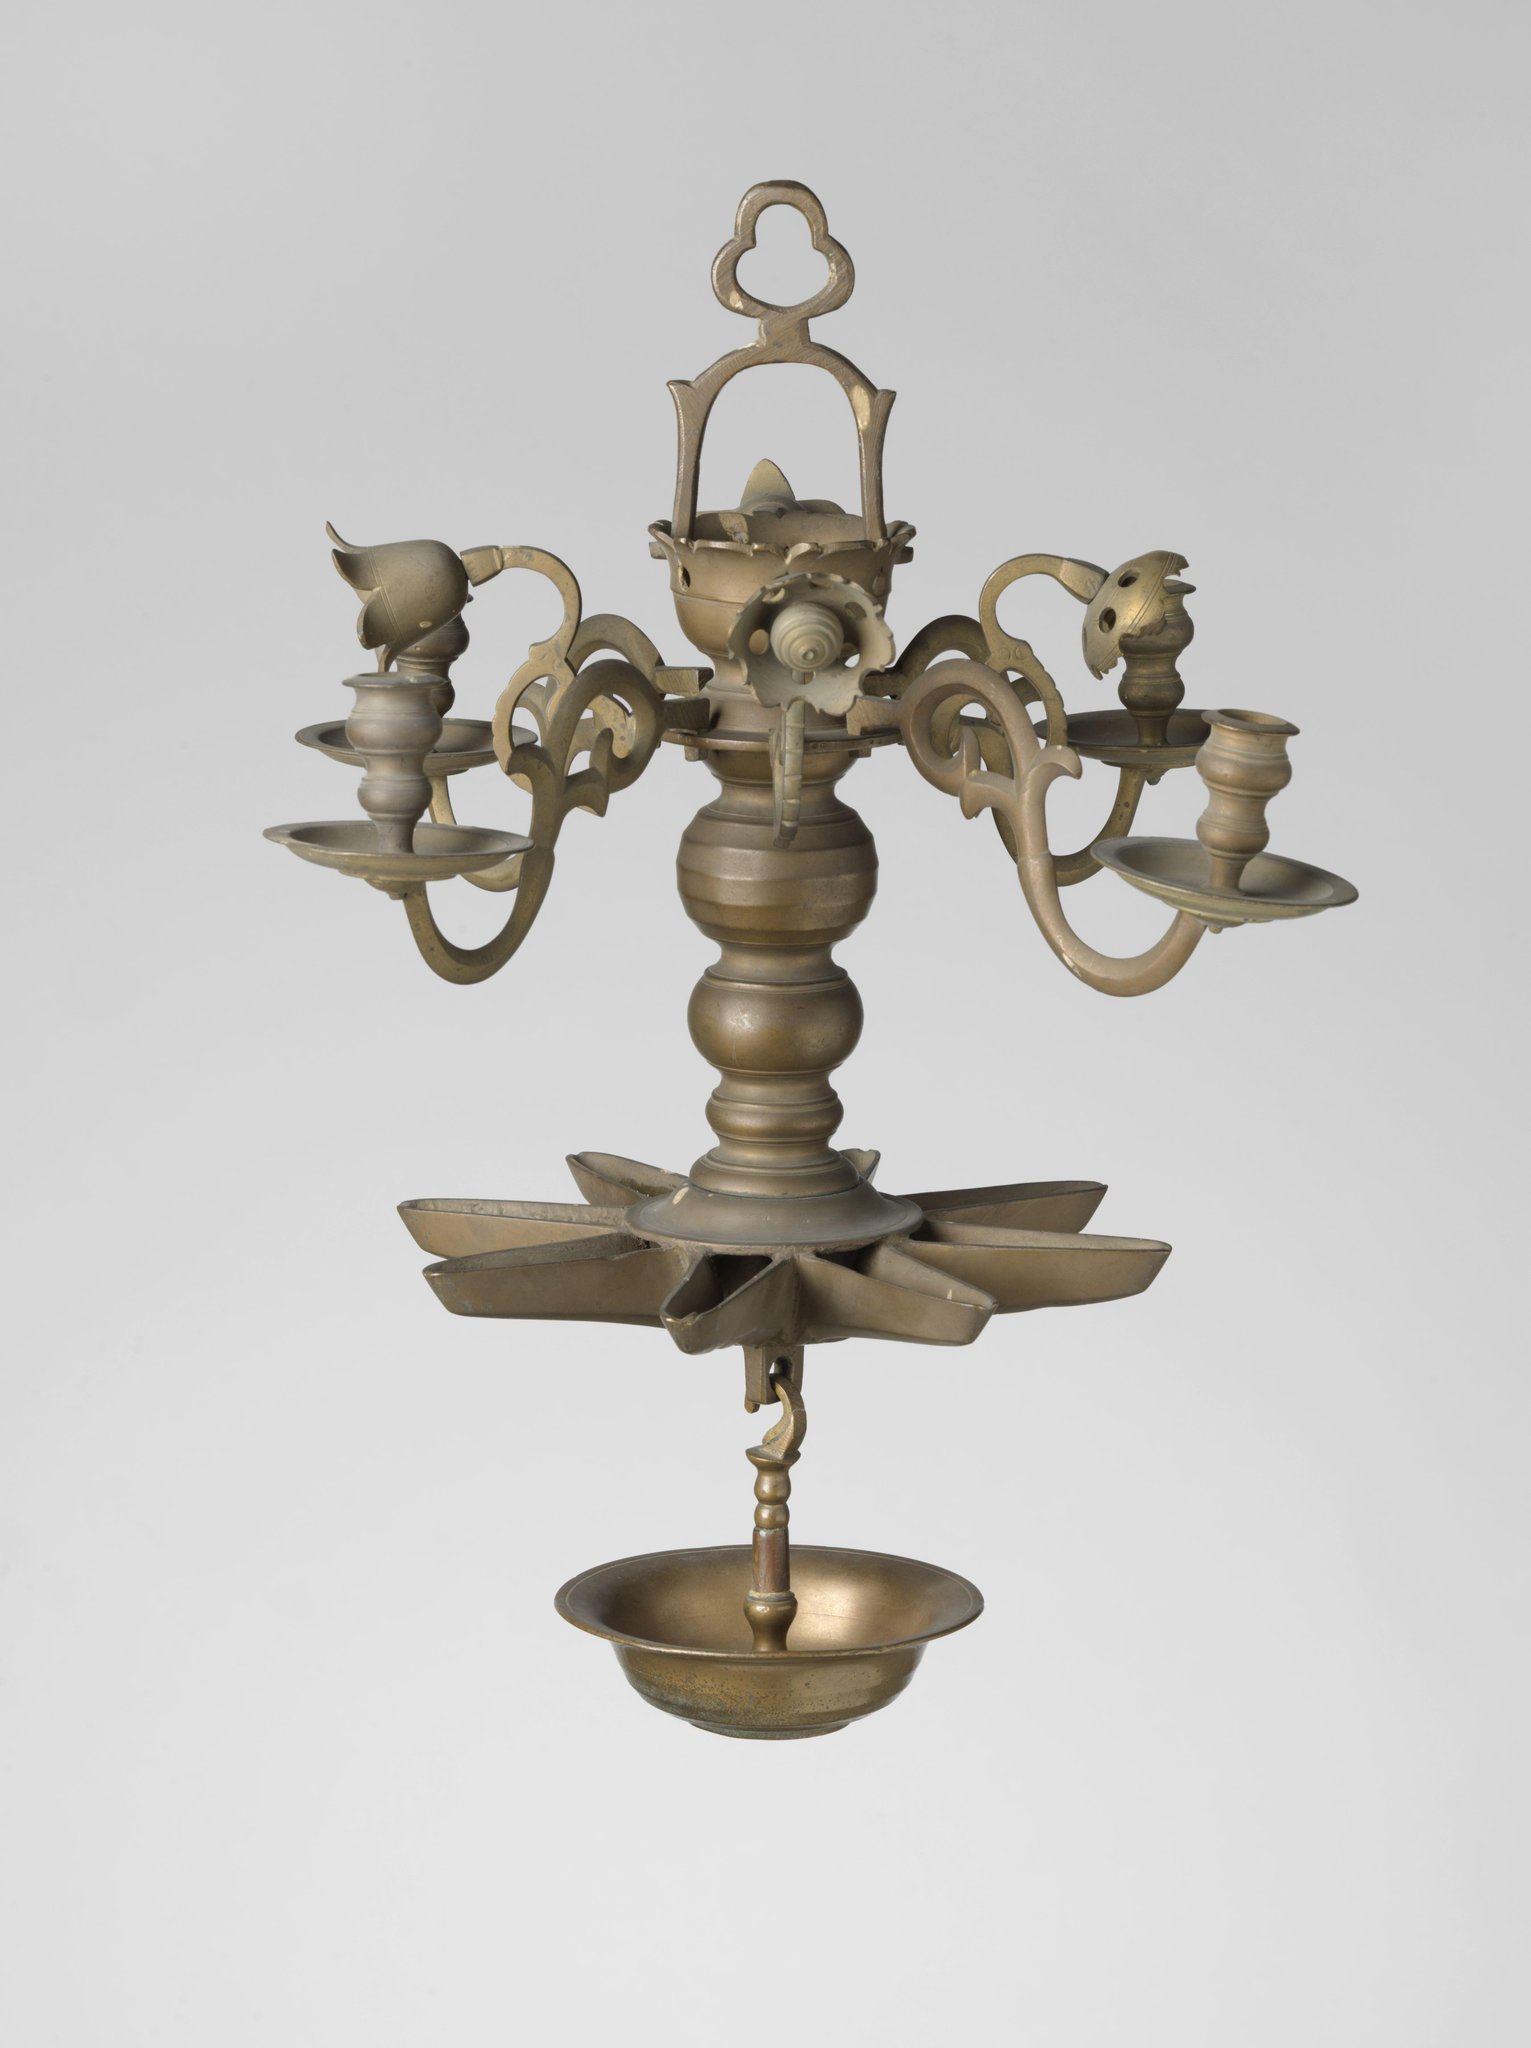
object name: sabbath lamp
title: Sabbathlamp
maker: Anonymous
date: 1700-1800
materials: brass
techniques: casting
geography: nuremberg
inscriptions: maker's mark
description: Het voorwerp bestaat uit de volgende gegoten delen: het hengsel, de stam, de oliebak, de druipbak, de vier armen, de vier sierelementen. Het hengsel heeft bovenaan een klaverbladvormig oog. De geprofileerde naar beneden toe versmallende stam is bovenaan kelkvormig, heeft vervolgens een standring met vier gaten en vier inkepingen (ter bevestiging van de armen en de sierelementen) en is daarna drie keer bolvormig geprofileerd. De achtpuntige stervormige oliebak, die aan de onderkant rond het oog een ingeslagen ornament heeft, is met een bajonetsluiting aan de stam bevestigd. Aan het oog hangt met een haakje de geprofileerde stang met de druipbak, waarin op de rand het teken van een engelenkop is ingeslagen. De S-vormige armen eindigen naar de stam toe in een krul en gaan naar buiten toe over in een plat bevestigingsdeel, waarin de bol- en holronde zich naar de voet verjongende houders op de geprofileerde ronde vetvangers zijn geschroefd. De vier sierelementen bestaan uit gestileerde bloemen, die twee aan twee gelijk zijn.